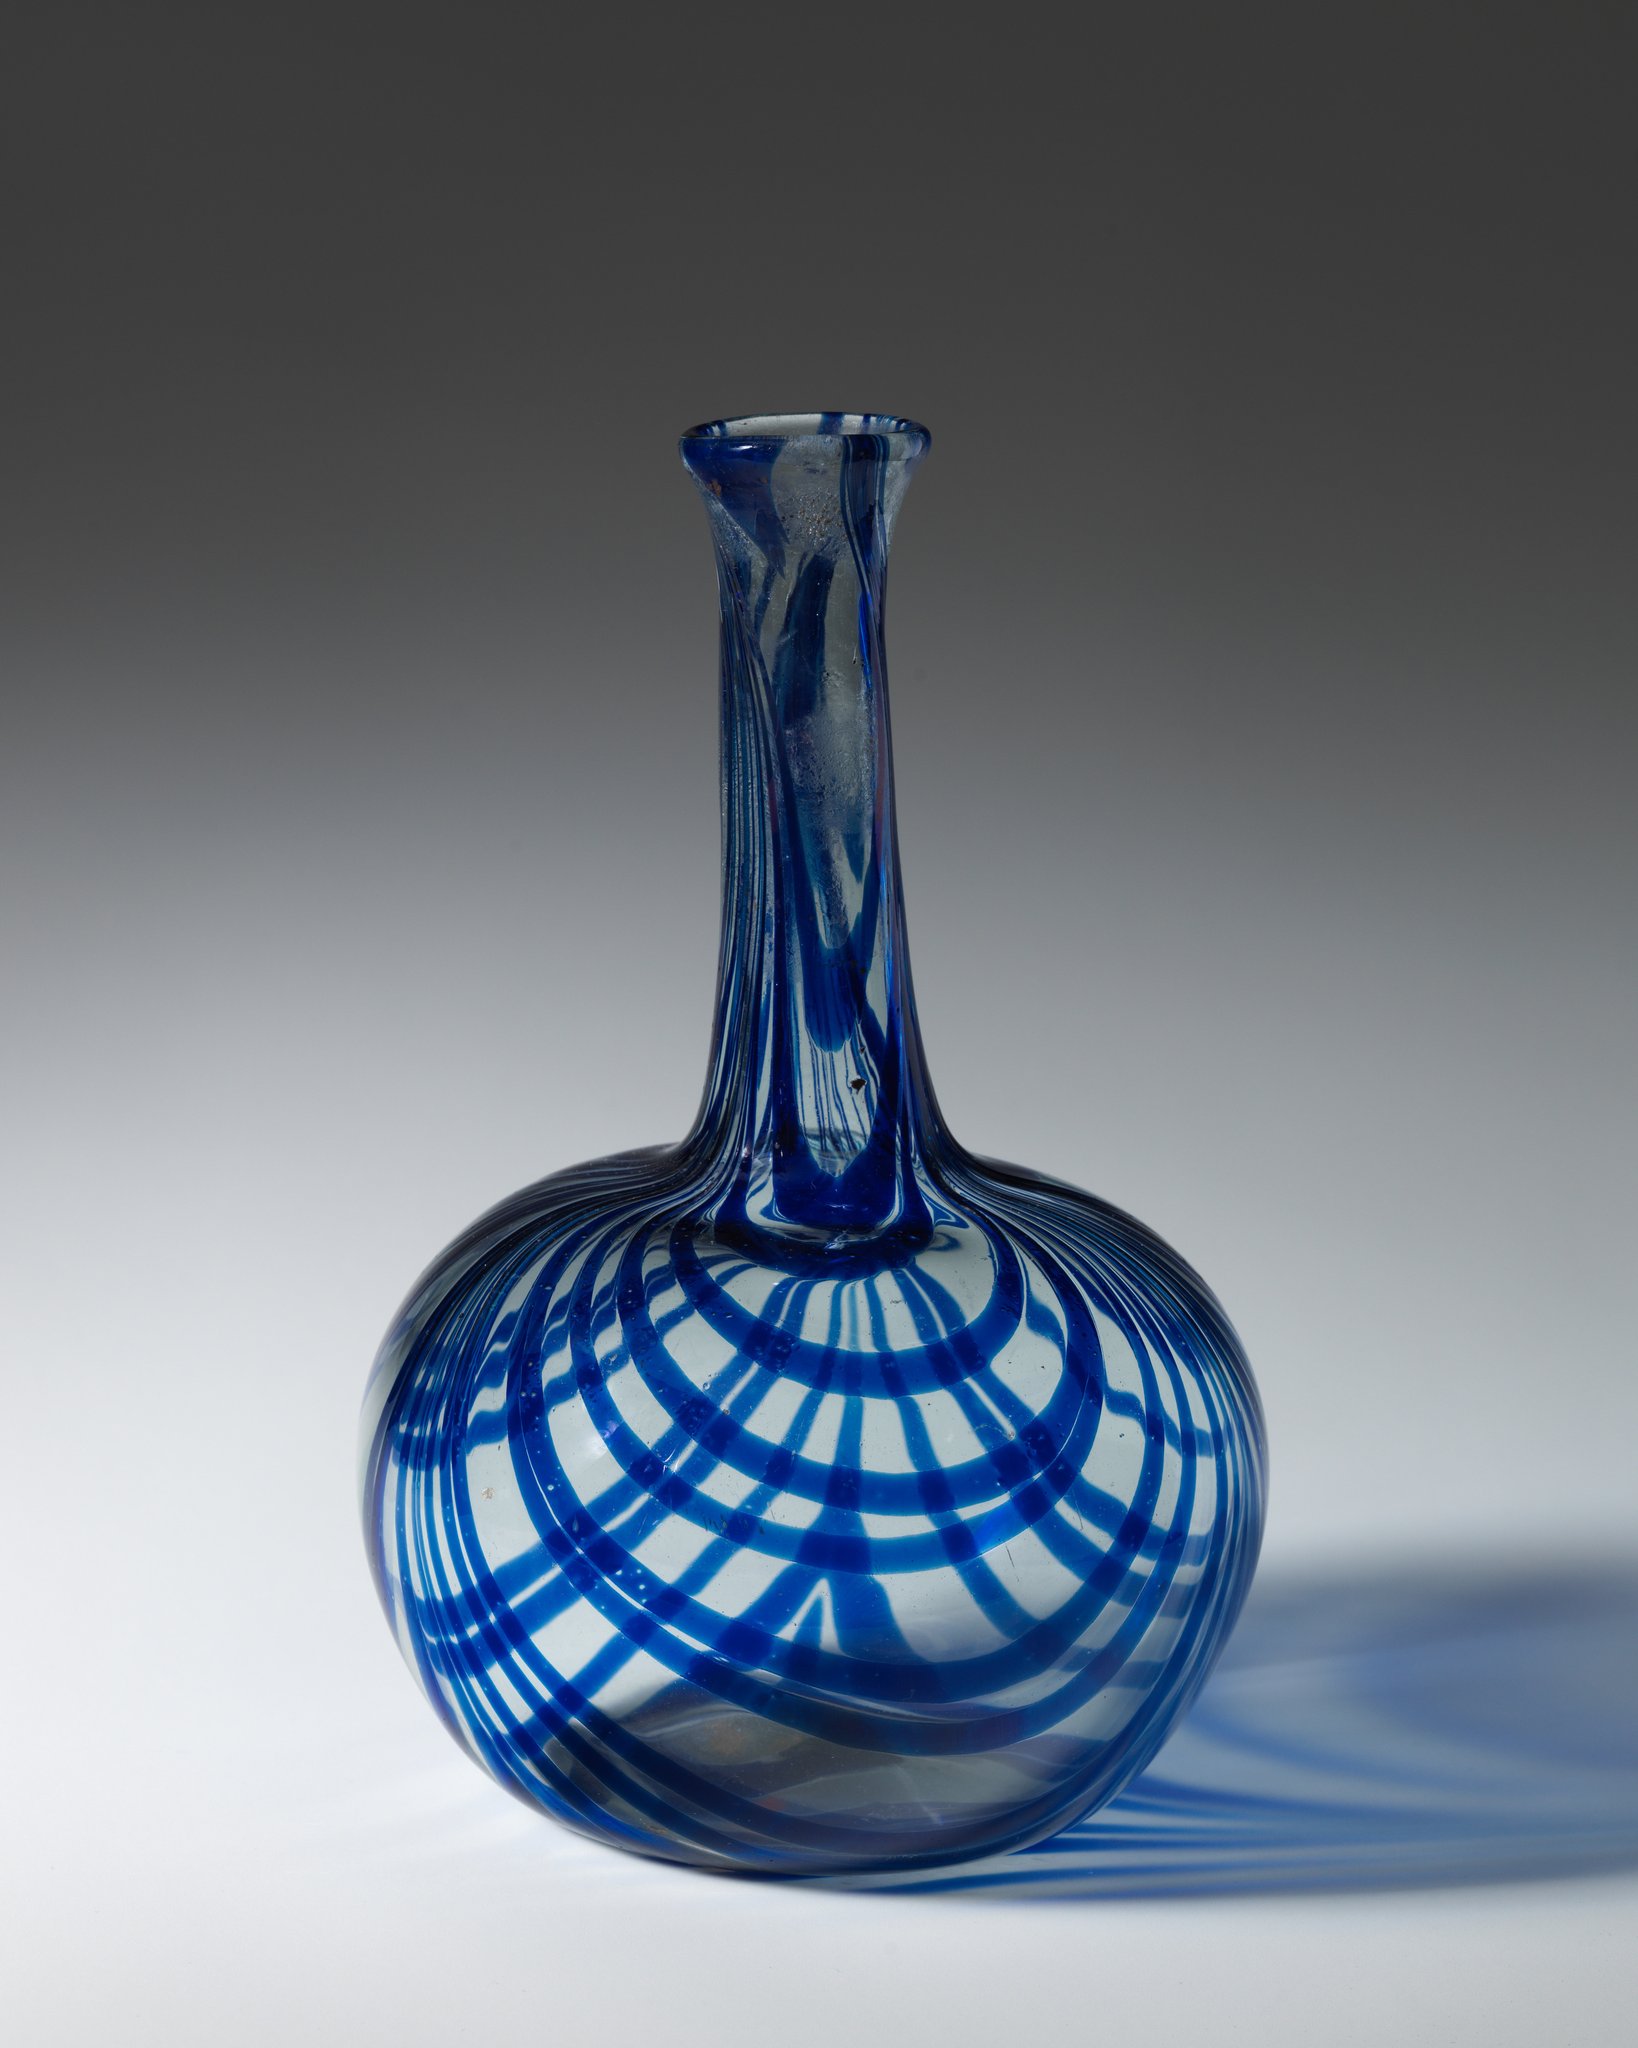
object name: bottle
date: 1767-1833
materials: glass